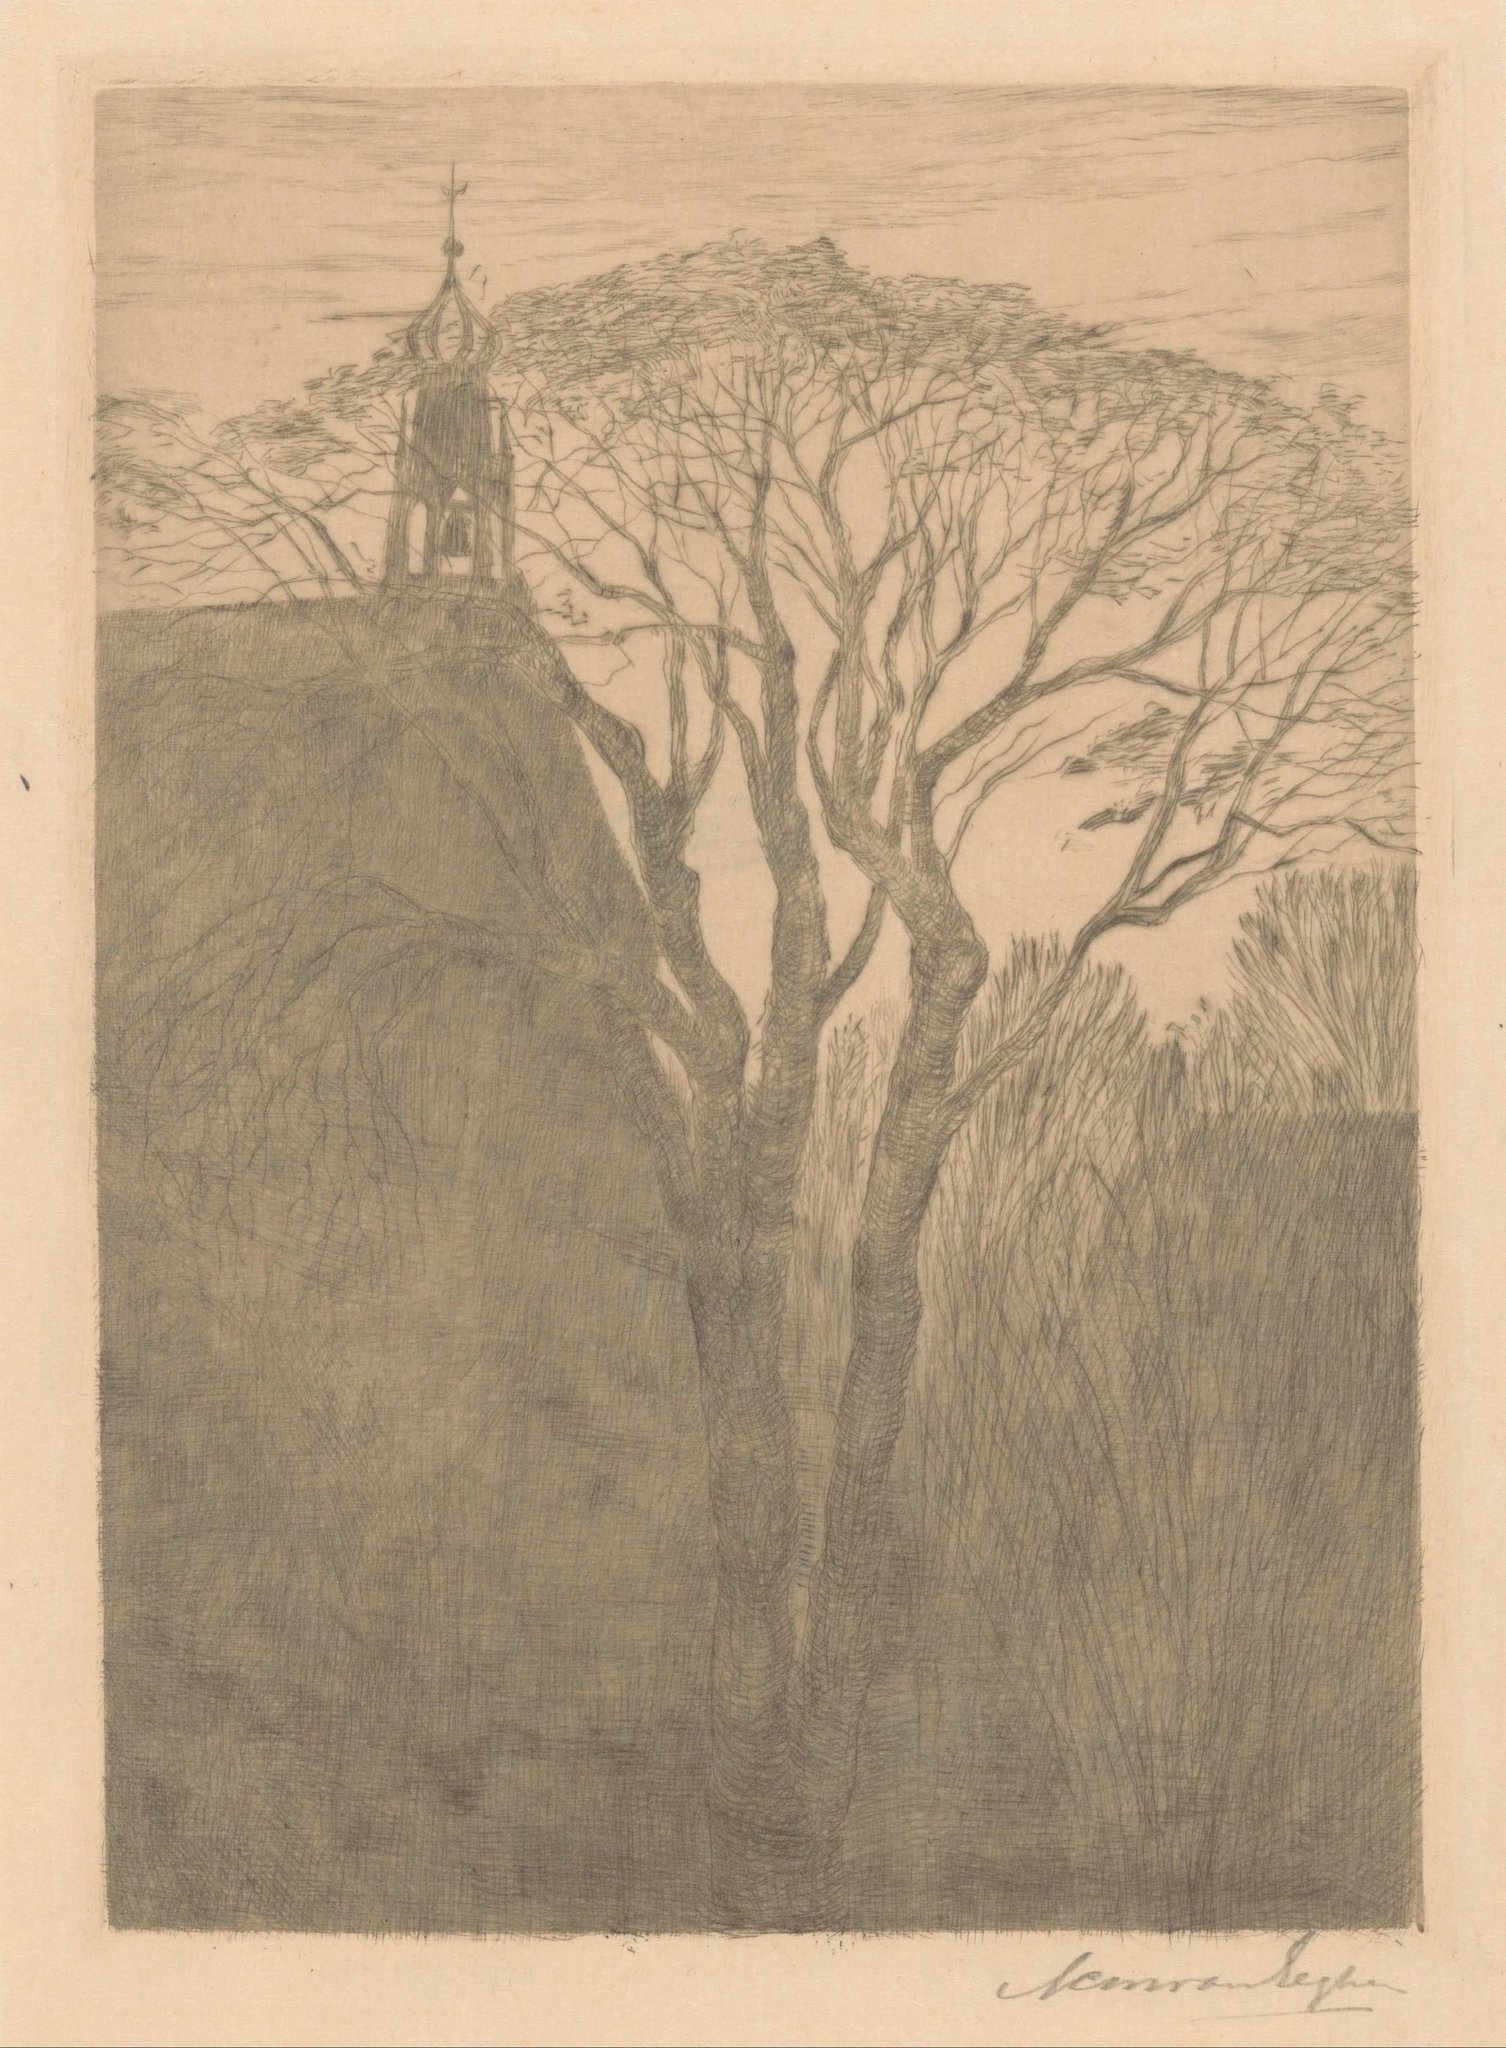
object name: print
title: Boom bij een kerk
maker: anna catharina maria van eeghen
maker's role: draughtsman, print maker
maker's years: 1878-1924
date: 1888-1924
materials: paper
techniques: etching, intaglio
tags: trees, church (exterior)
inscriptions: collector's mark: Lugt 2760, collector's mark: Lugt 2228